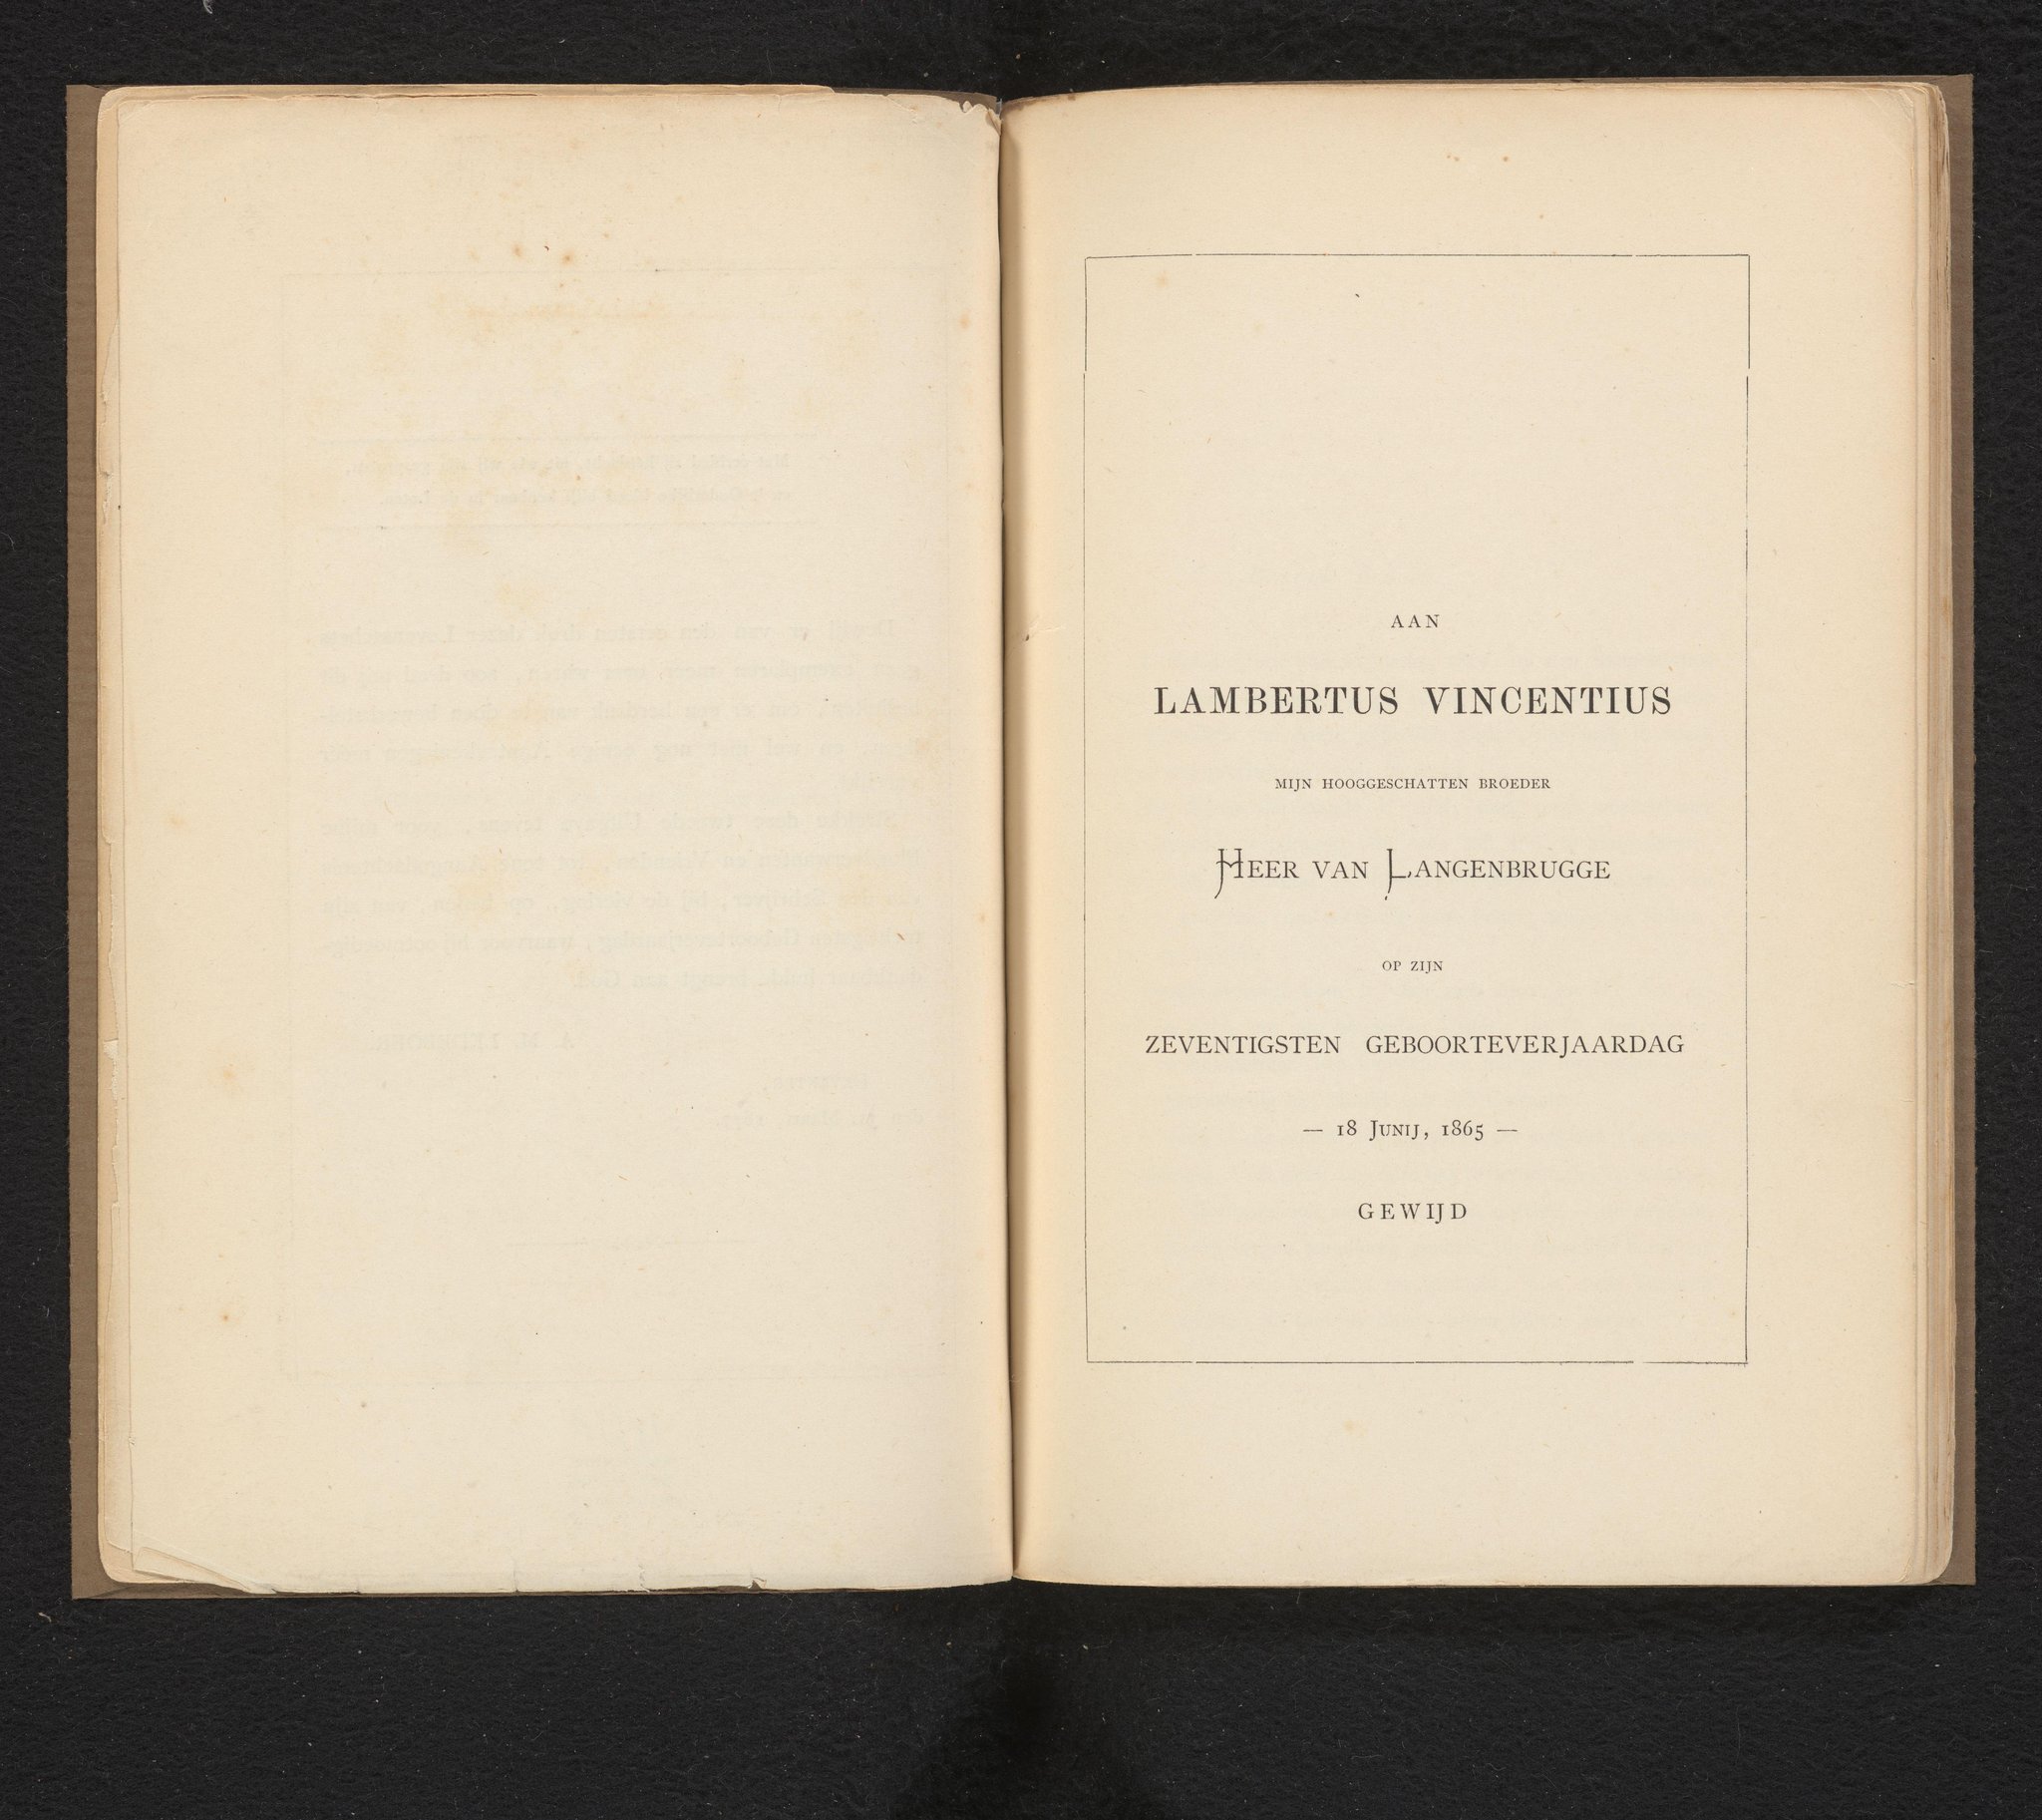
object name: book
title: Bernardus Ledeboer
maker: adrianus marinus ledeboer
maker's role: bookseller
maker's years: 1797-1887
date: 1877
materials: cardboard, paper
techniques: albumen print, printing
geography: deventer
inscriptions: bookplate: ‘Ex Libris/ Mr. W.C. Baert de Waarde’